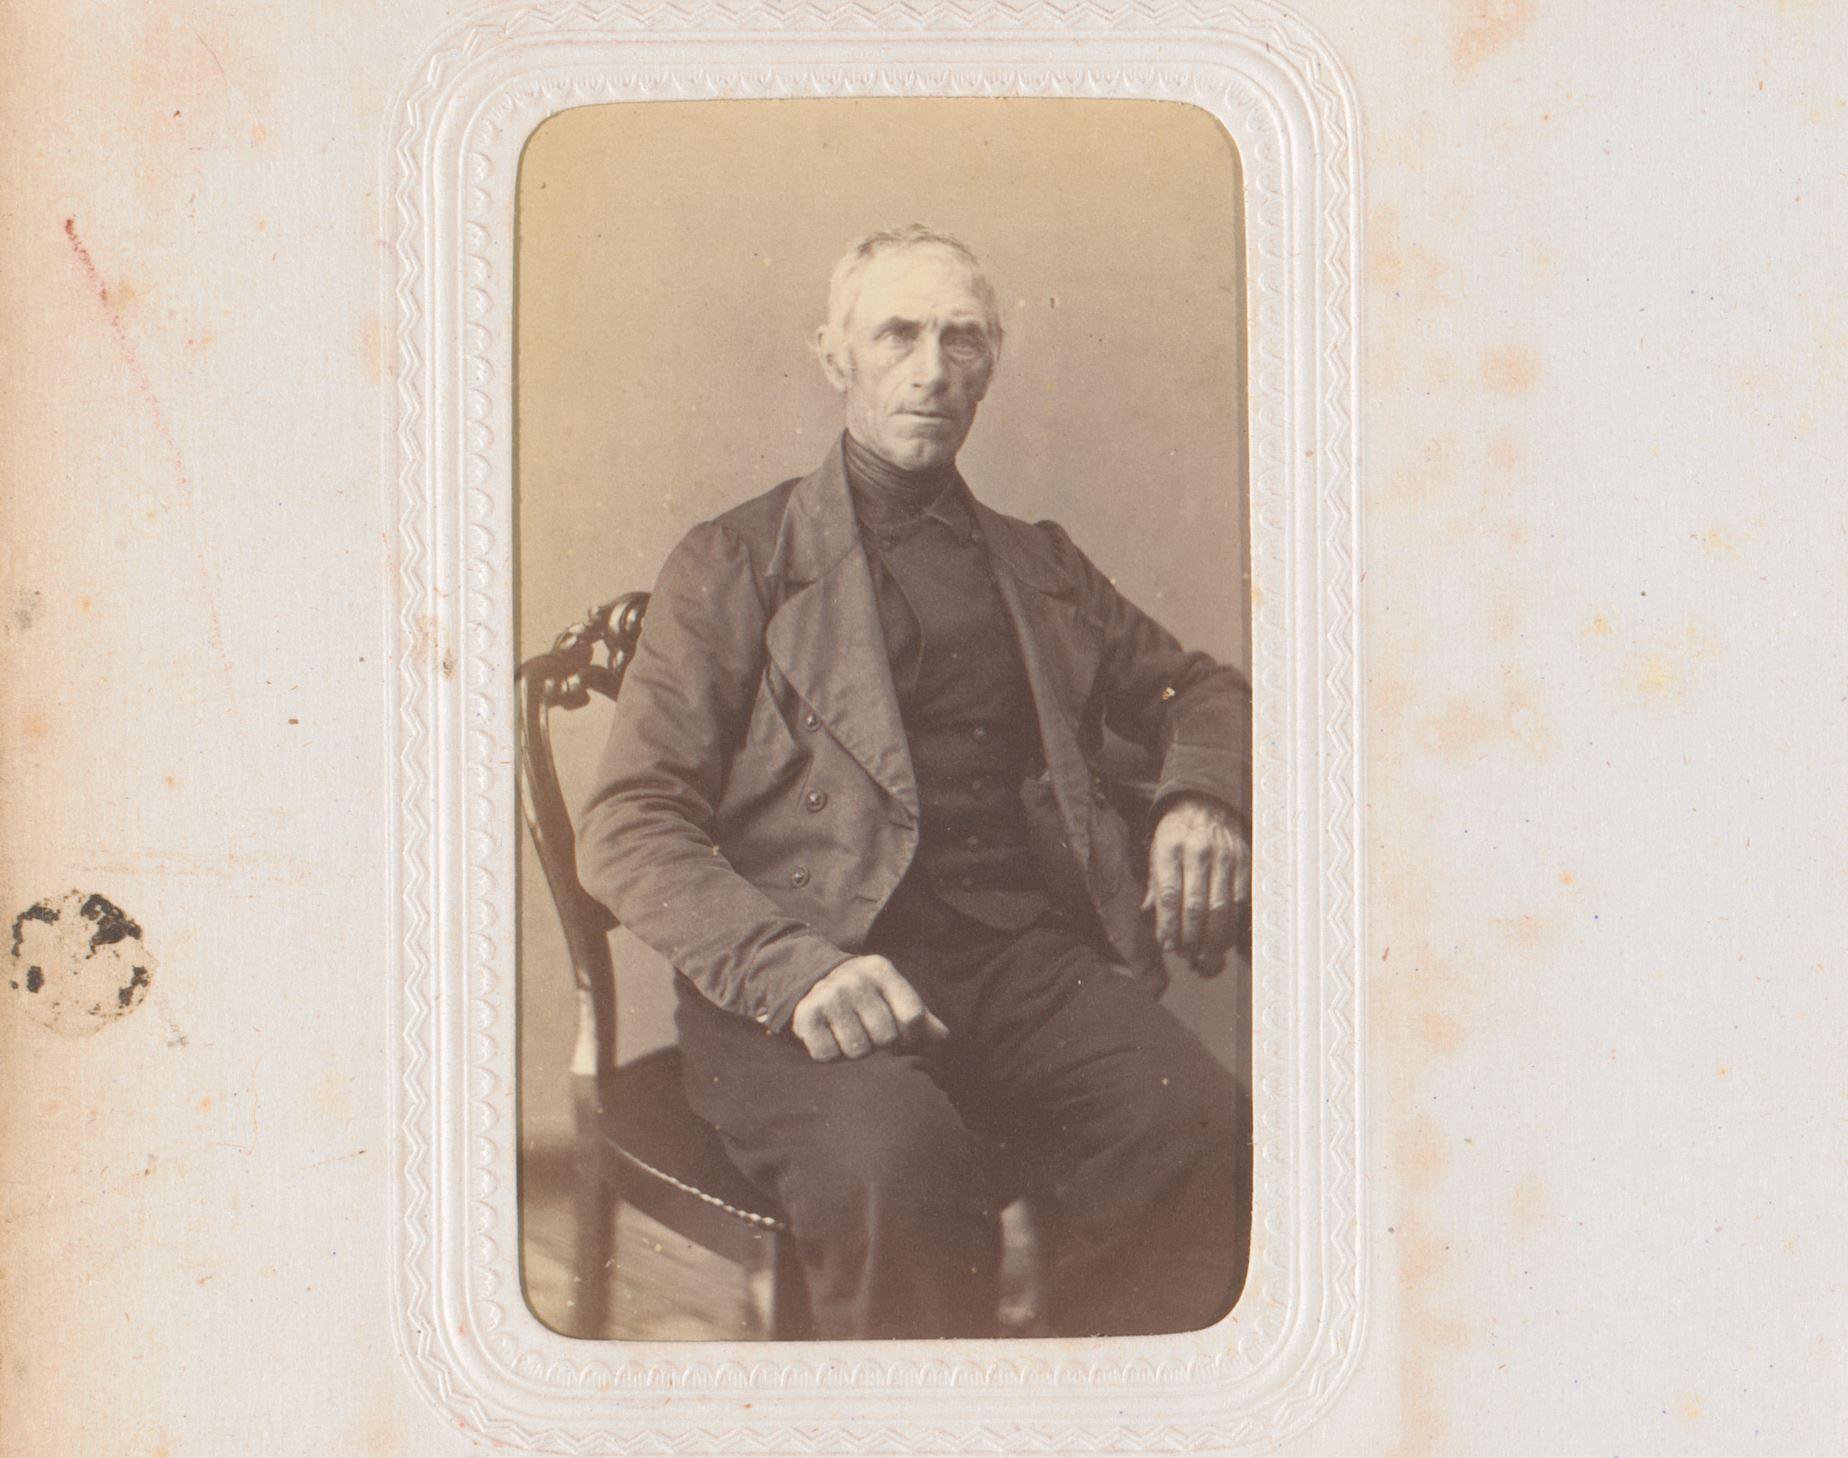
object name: carte de visite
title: Portret van een man, zittend aan een tafel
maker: kornelis willem schorteldoek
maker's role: boekbinder, fotograaf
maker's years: 1800-1885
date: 1855-1885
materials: cardboard, photographic support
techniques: albumen print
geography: gorinchem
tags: sitting figure, historical persons, table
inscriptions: inscription: ‘SCHORTELDOEK/ PHOTOGRAAF/ GORINCHEM/ Groote Markt’